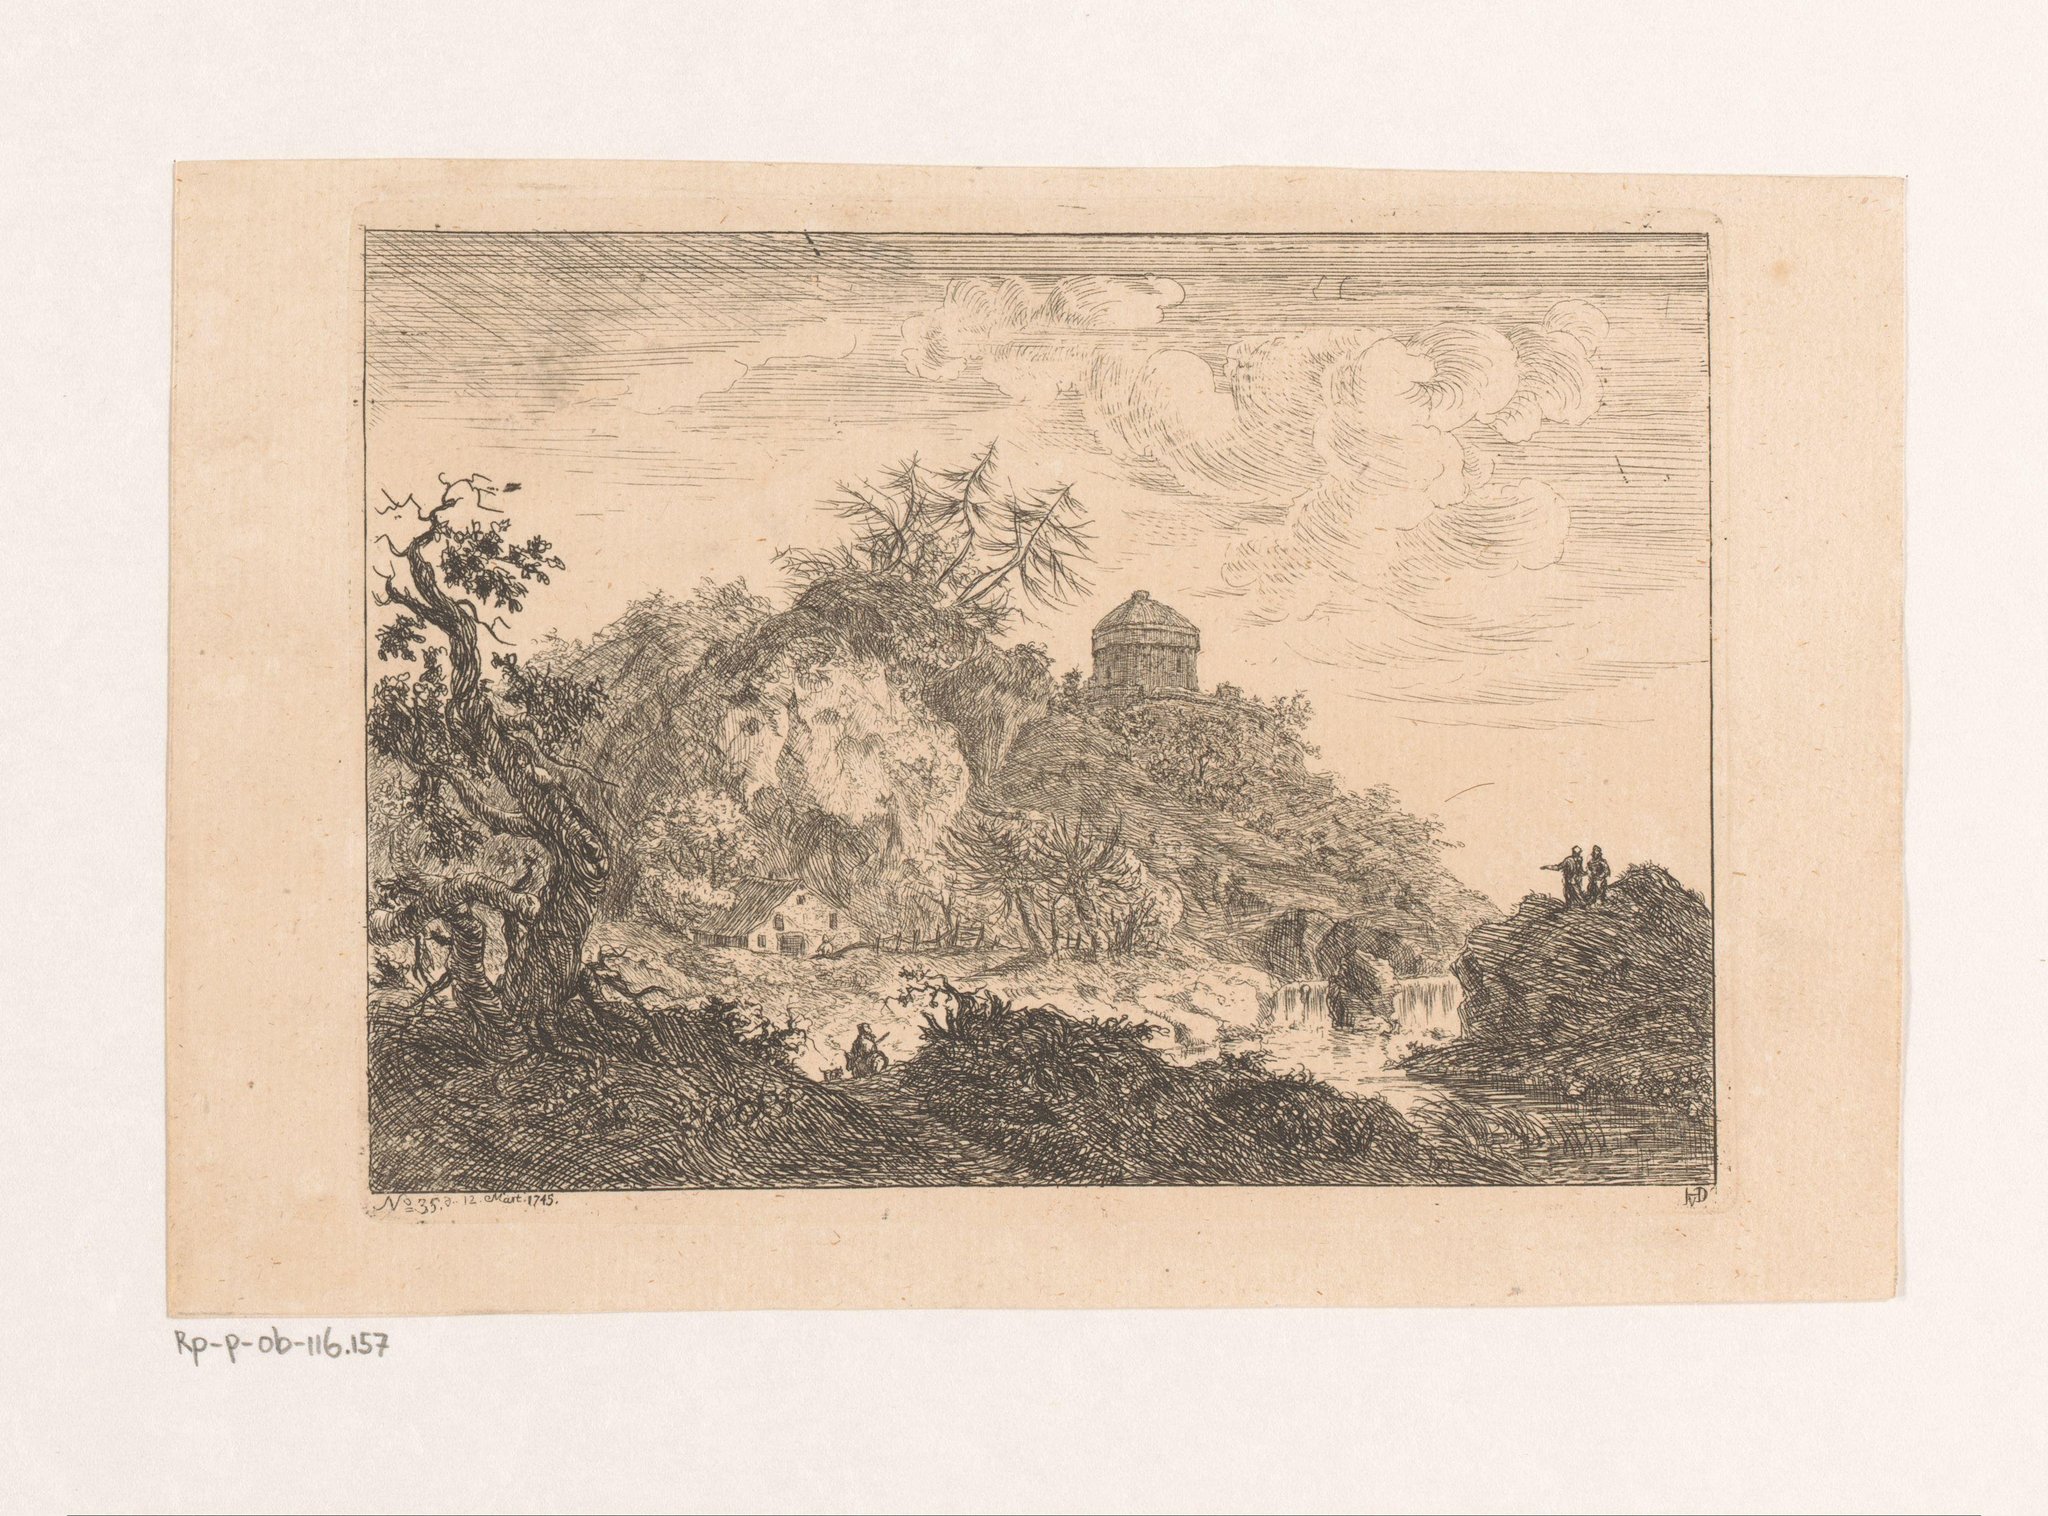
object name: print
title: Heuvellandschap met waterval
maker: christian ludwig von hagedorn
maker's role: painter, print maker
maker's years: 1712-1780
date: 1745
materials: paper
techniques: etching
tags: waterfall, (high) hill (+ landscape with figures, staffage)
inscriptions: collector's mark: Lugt 240